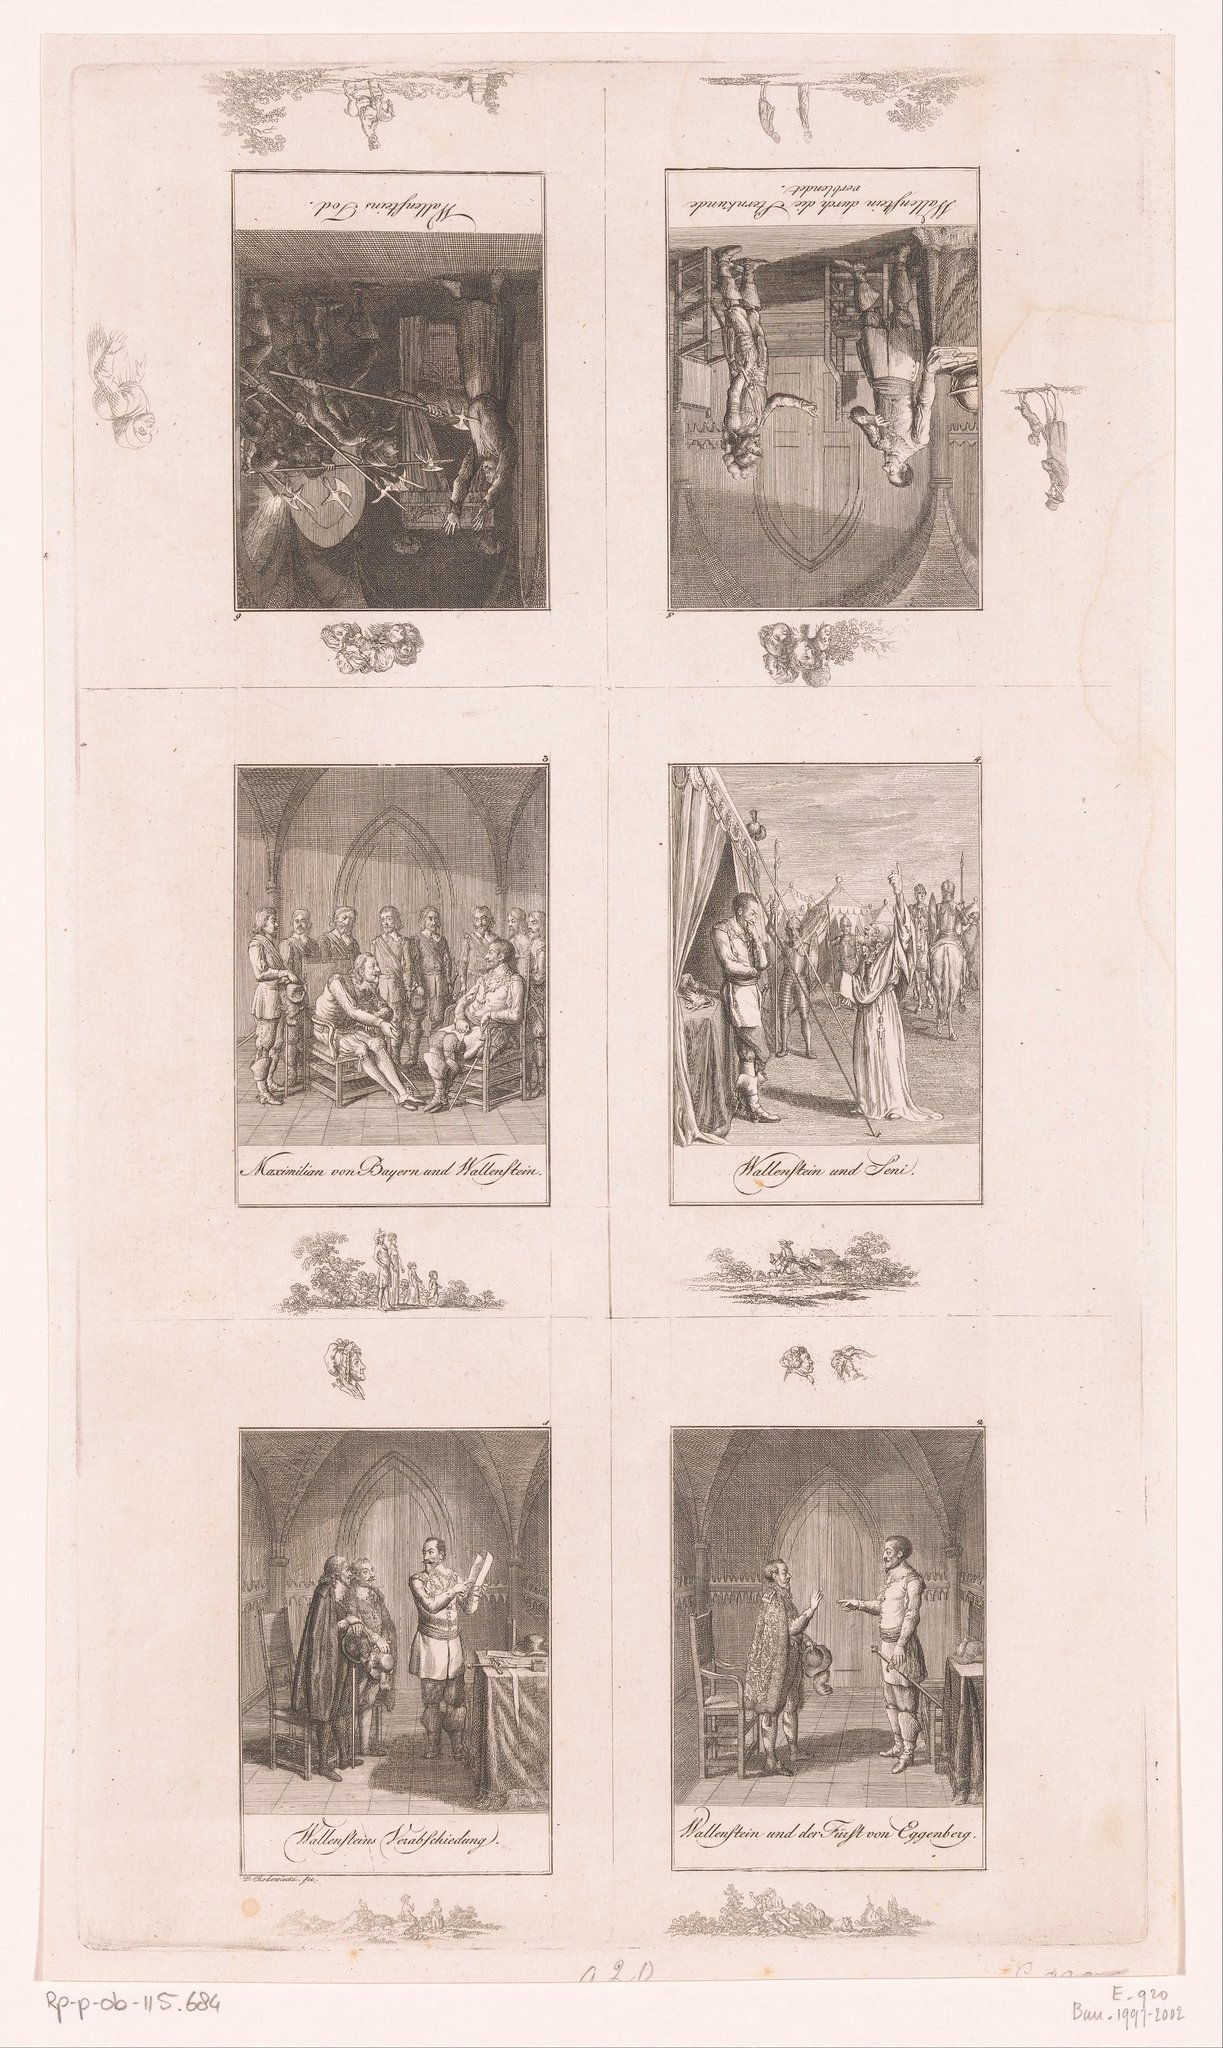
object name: print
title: Zes voorstellingen uit het leven van veldheer Wallenstein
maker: daniel nikolaus chodowiecki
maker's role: draughtsman, print maker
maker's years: 1726-1801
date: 1799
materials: paper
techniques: etching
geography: berlin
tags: (military) camp with tents, violent death, being killed; being mishandled and maltreated; seeking death, meeting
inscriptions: collector's mark: Lugt 2228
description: Prenten gebruikt voor: Woltmann, Karl Ludwig von. Historischer Kalender auf das Gemein-Jahr 1803 (...). Berlijn: Johann Friedrich Unger, s.a.